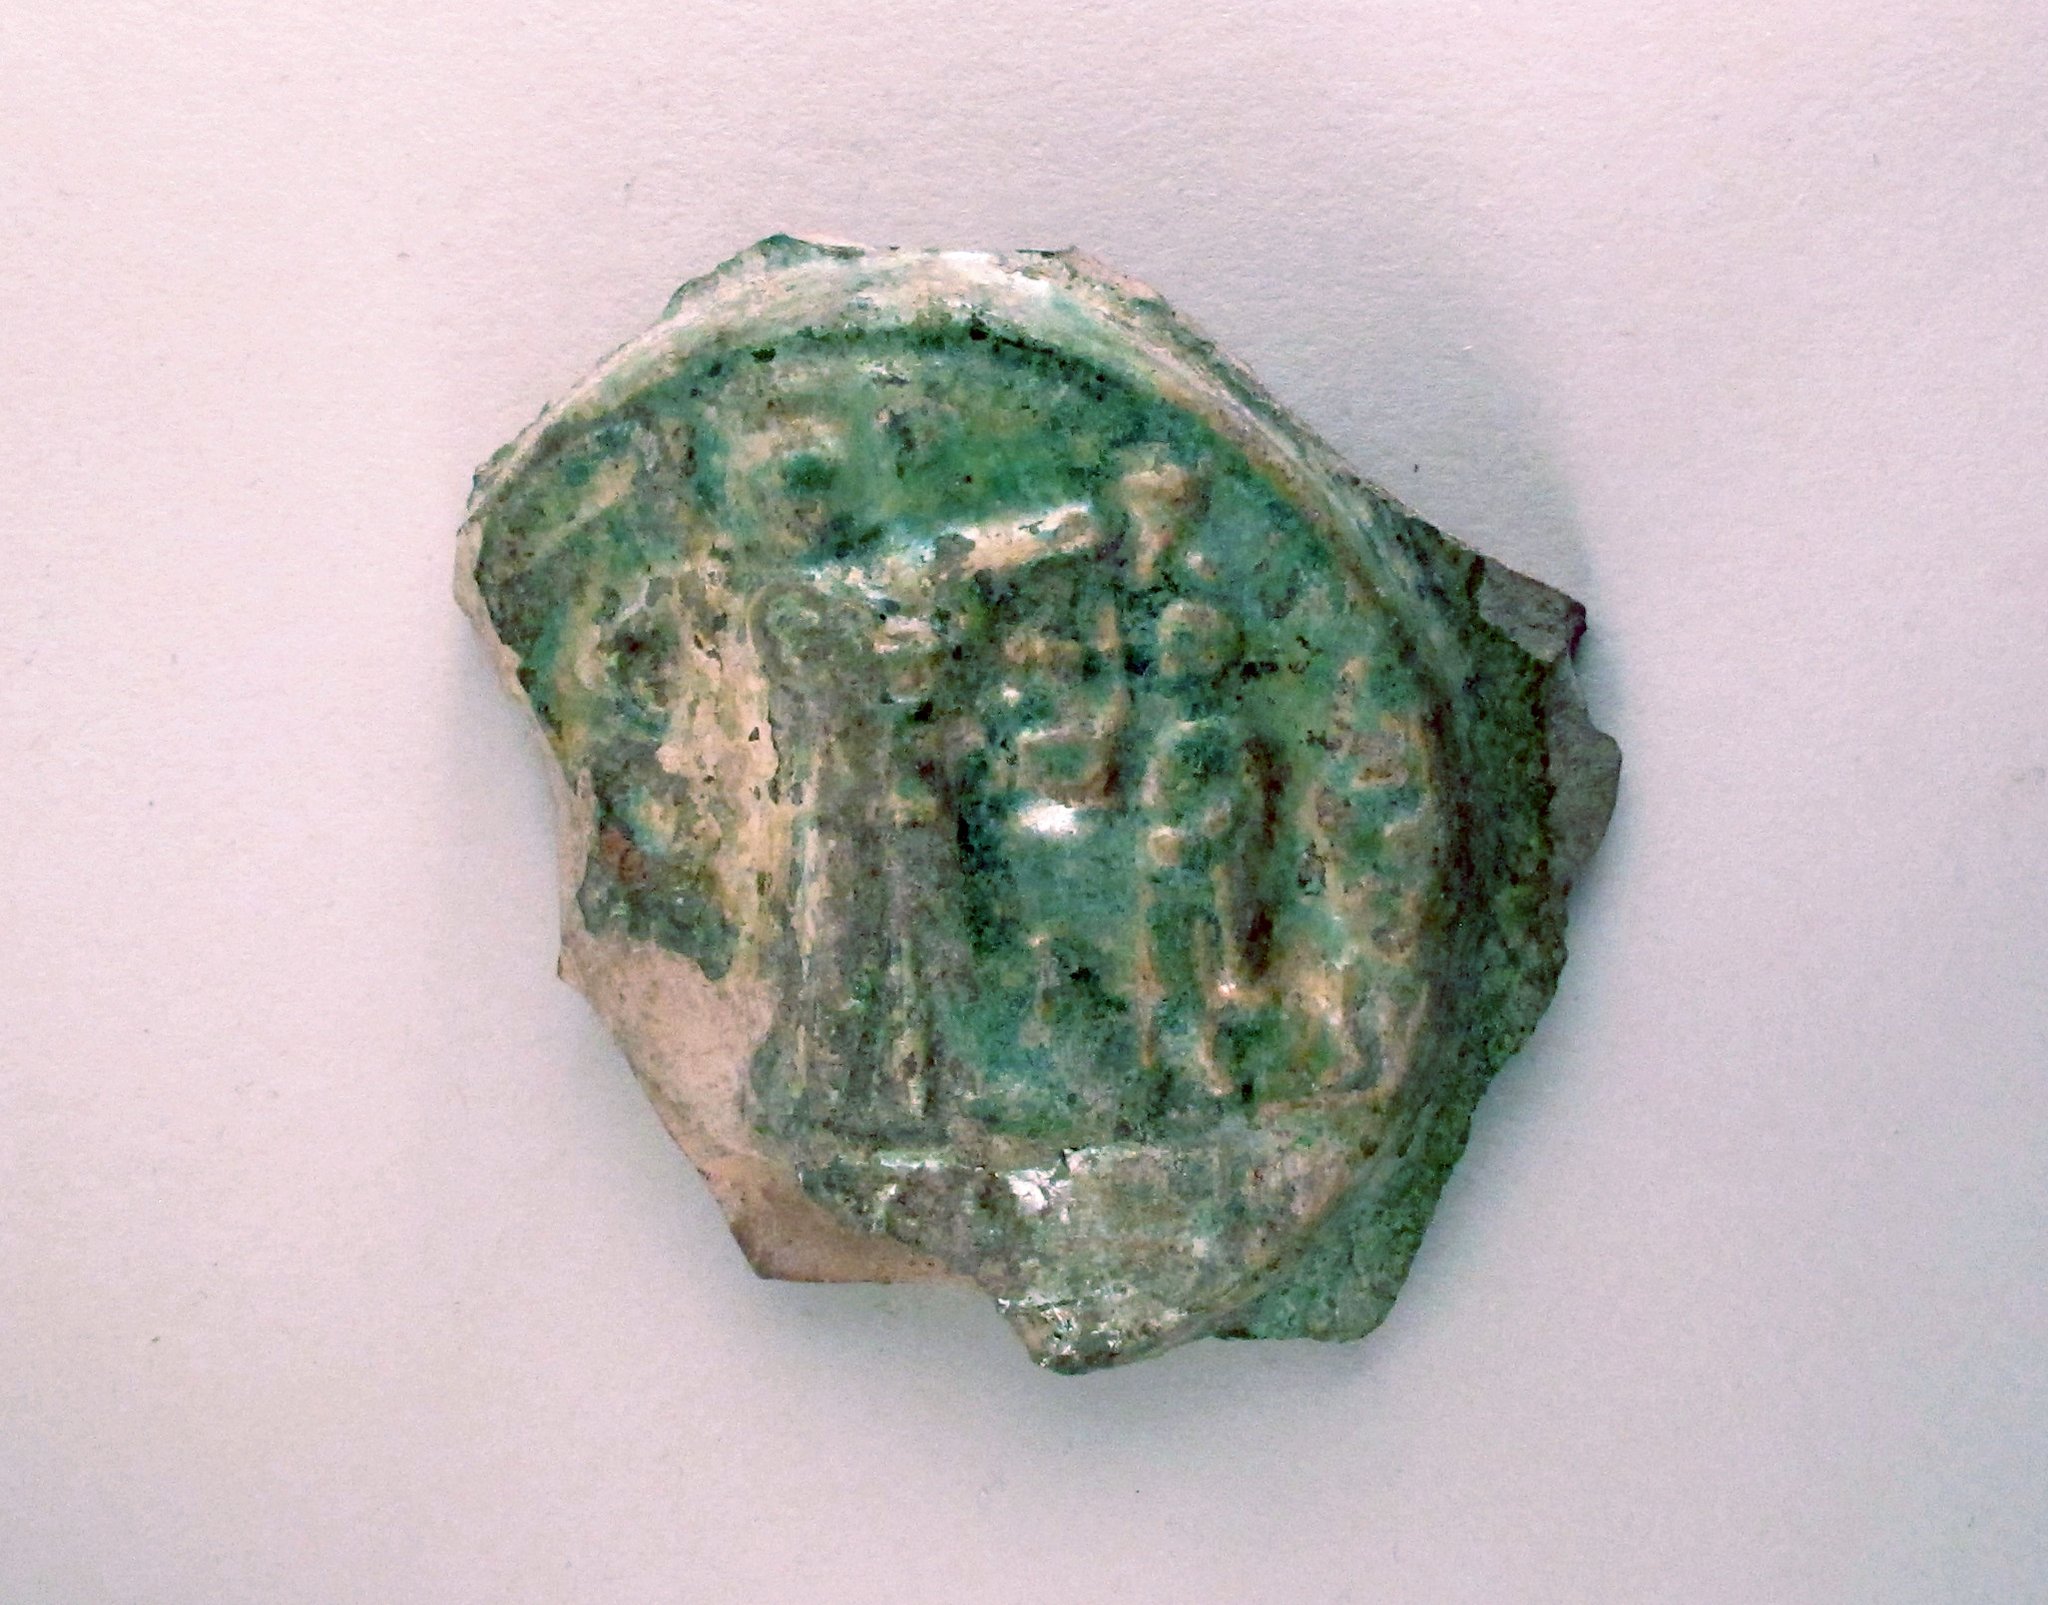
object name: vase fragment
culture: roman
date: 670 BCE-330 CE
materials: terracotta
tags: apollo